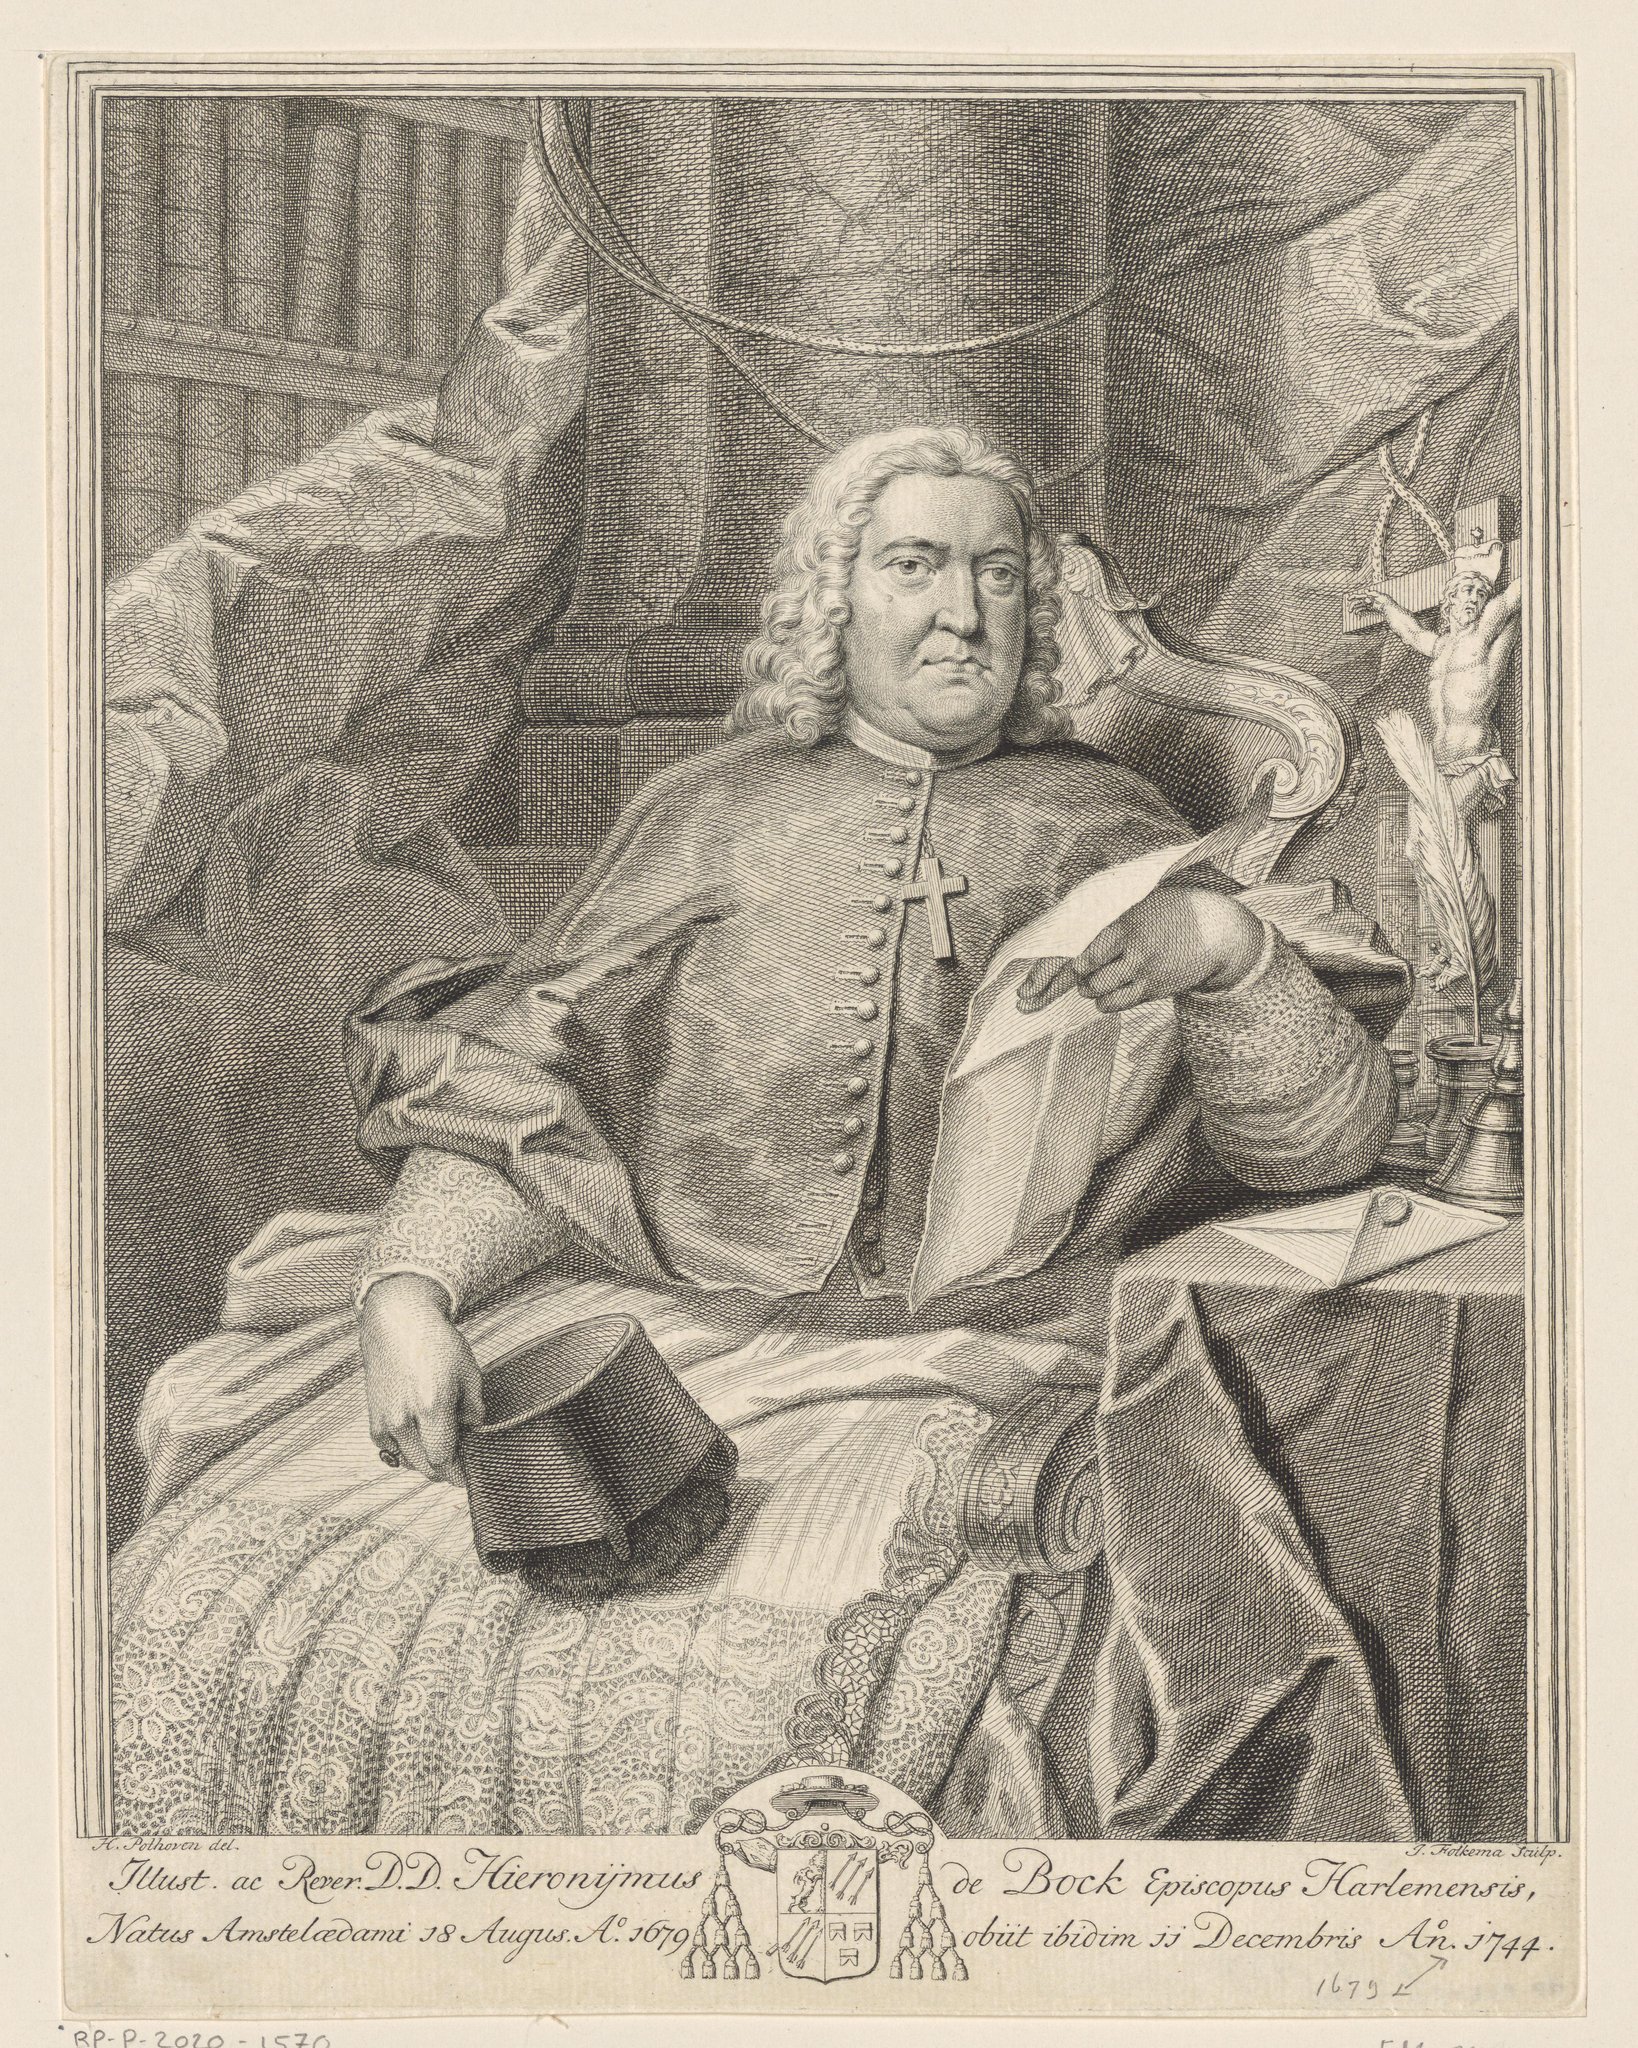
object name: print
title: Portret van Hieronymus de Bock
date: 1744-1767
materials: paper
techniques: engraving, etching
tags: archbishop, bishop, etc. (roman catholic), historical persons, armorial bearing, heraldry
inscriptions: collector's mark: Lugt 240